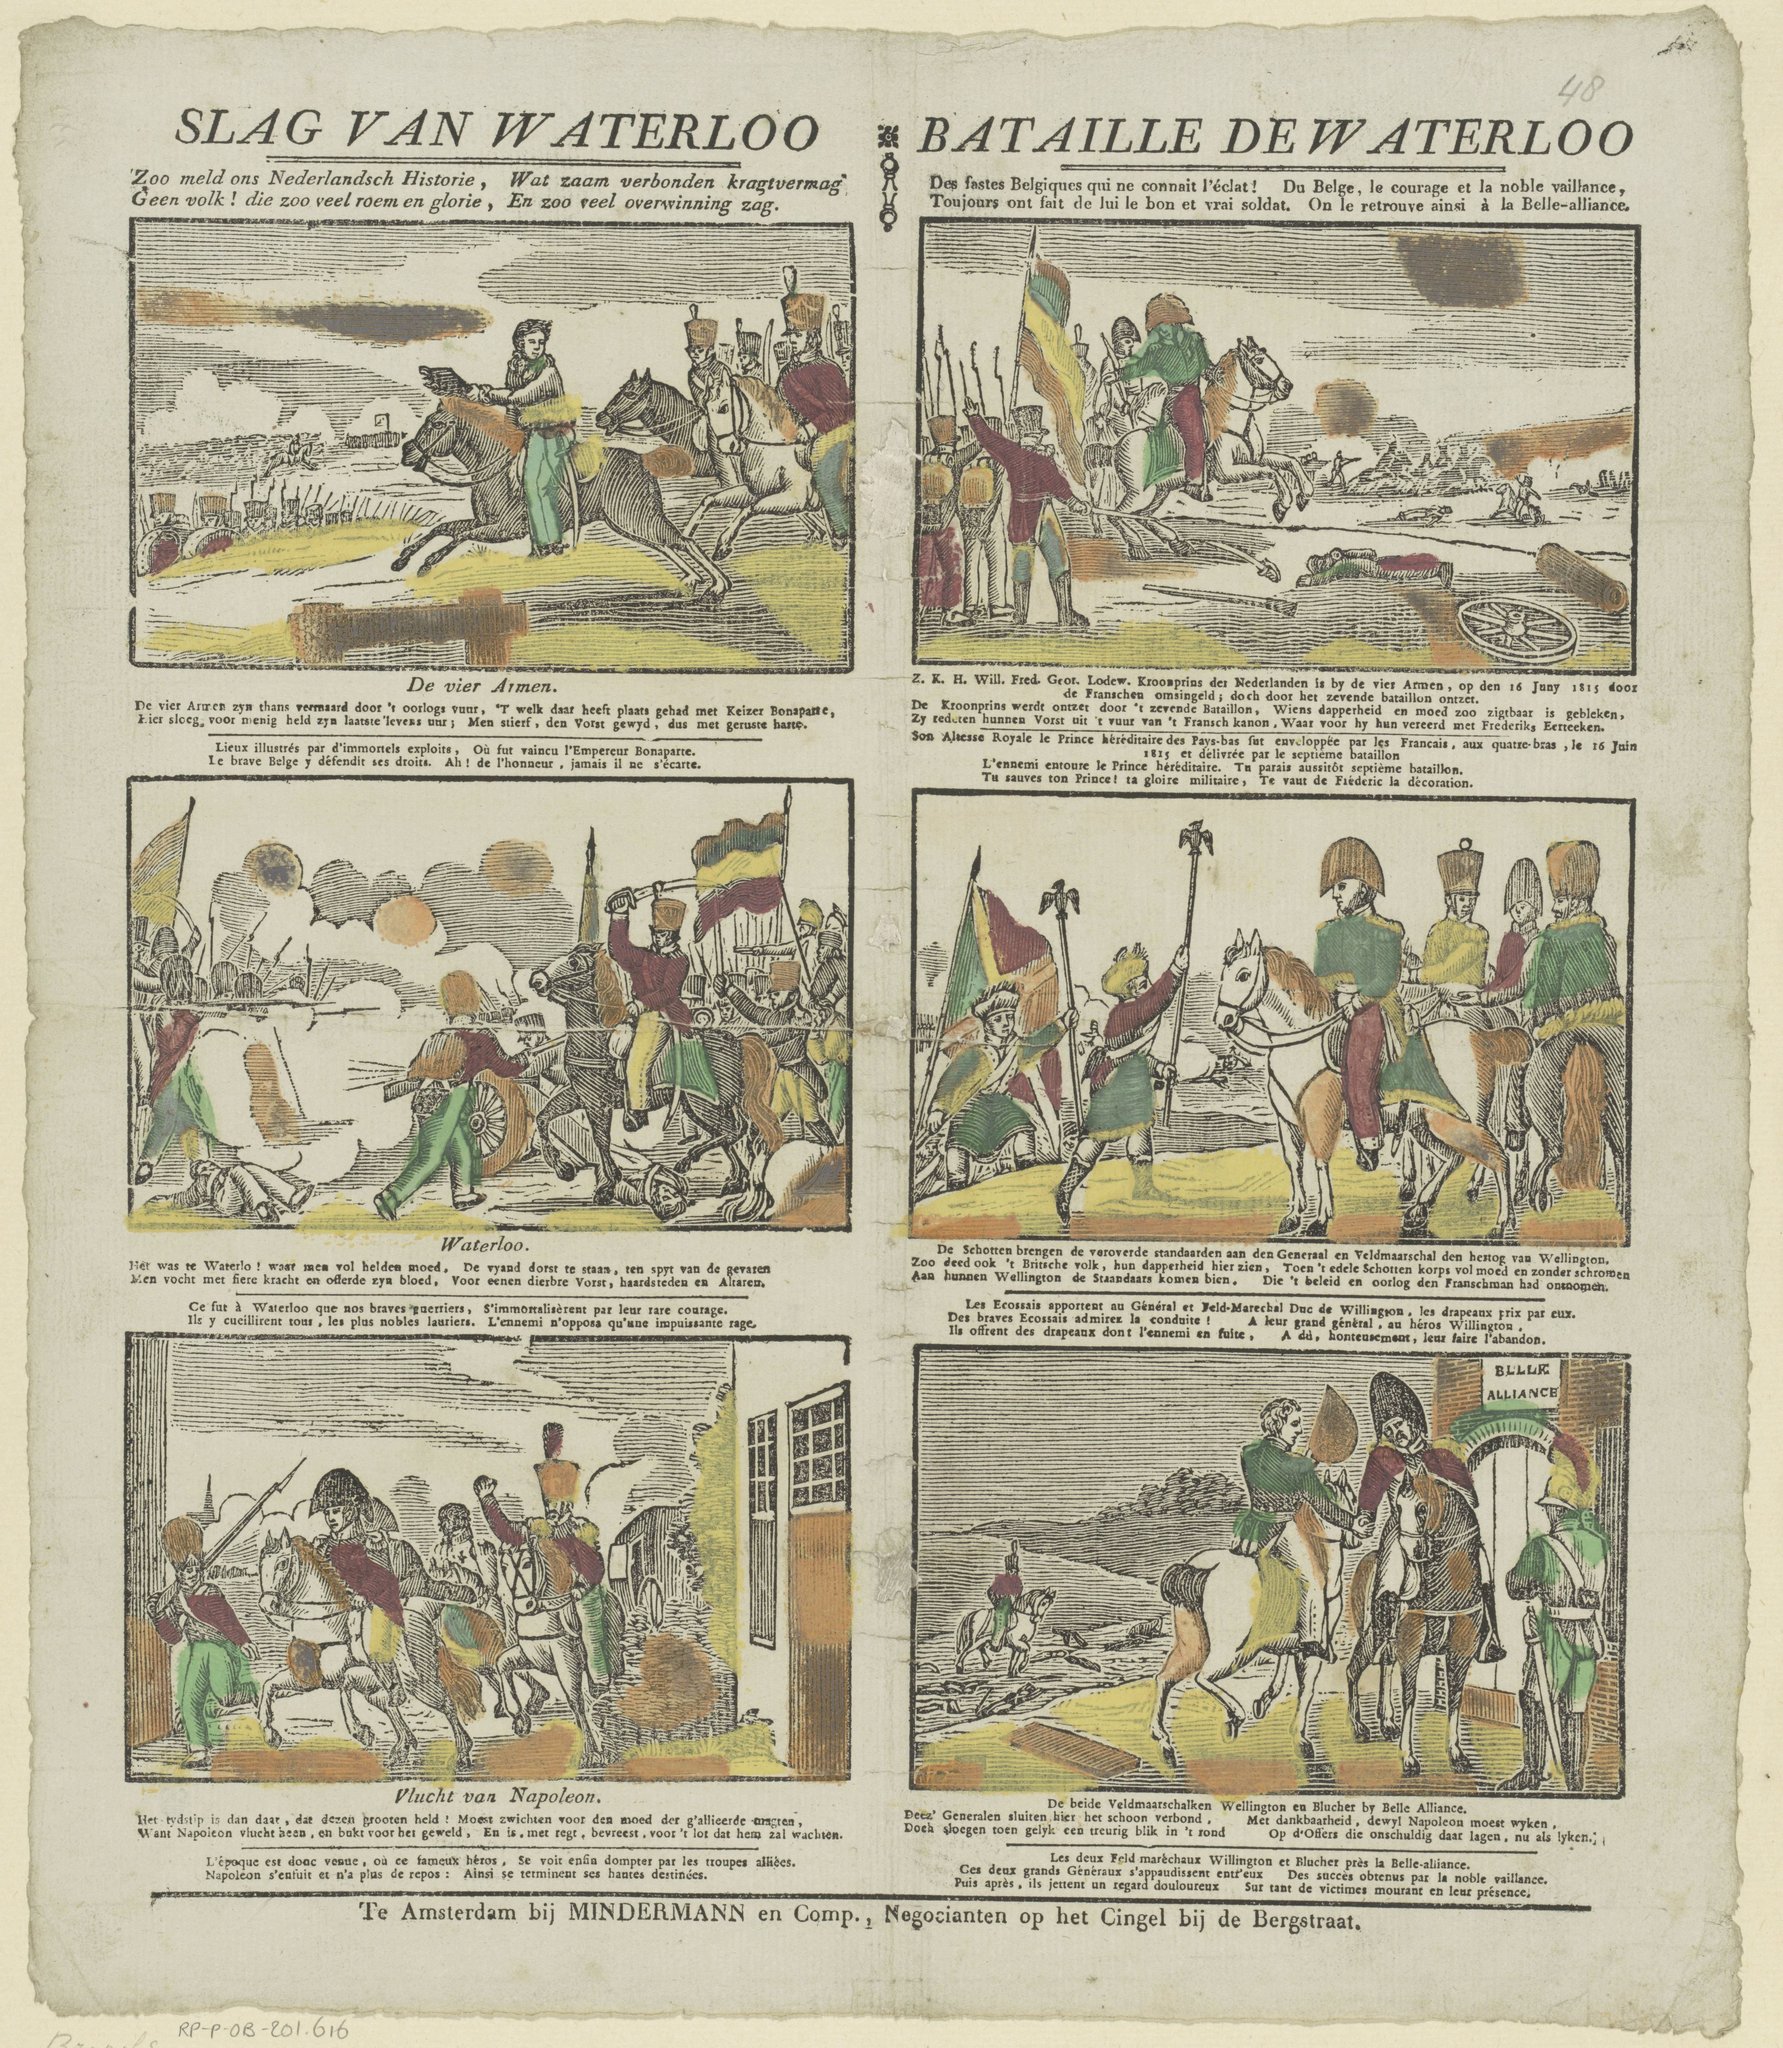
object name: popular print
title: Slag van Waterloo / Bataille de Waterloo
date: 1814-1848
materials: paper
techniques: colour, letterpress printing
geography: amsterdam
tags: battle, the soldier; the soldier's life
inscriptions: collector's mark: Lugt 2760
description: Blad met 6 voorstellingen over de Slag bij Waterloo. Onder elke voorstelling een vierregelig vers in het Nederlands en in het Frans.